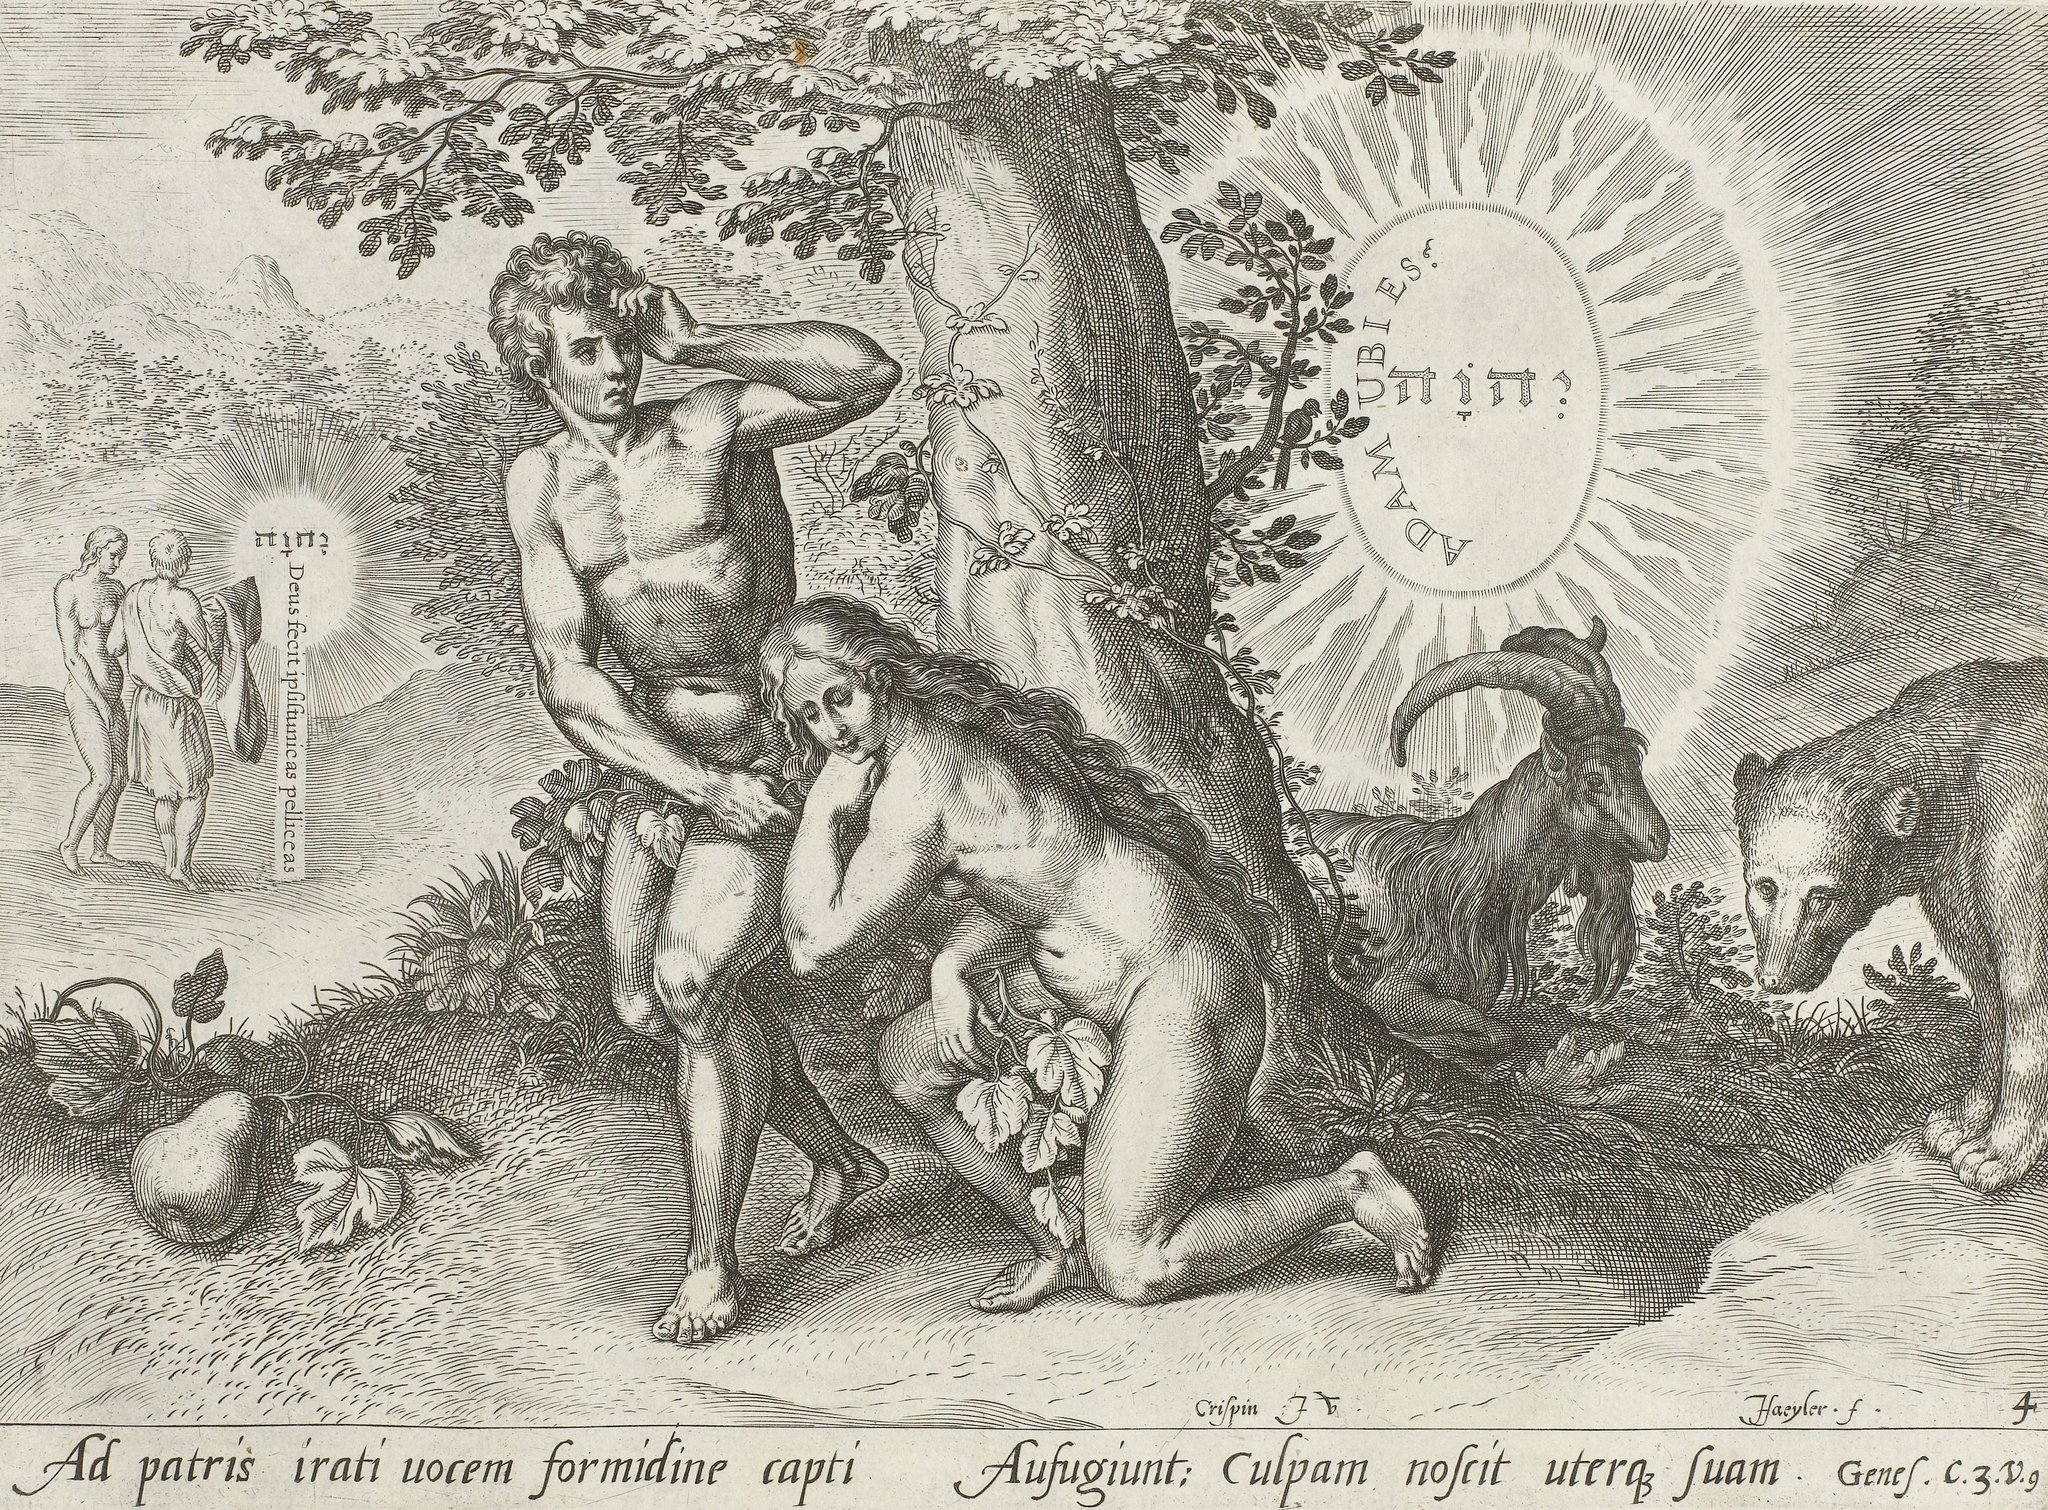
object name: album leaf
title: Schepping en zondeval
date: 1643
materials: paper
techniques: engraving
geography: amsterdam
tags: adam and eve are clothed by god, beasts of prey, predatory animals: bear, adam and eve hide from god, god calls adam and eve to account for their deed, adam and eve discover their nakedness; they cover themselves with their hands or with leaves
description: Adam en Eva hebben na het eten van een vrucht van de boom van de kennis van goed en kwaad ontdekt dat ze naakt zijn. Ze bedekken zich met bladeren en verbergen zich voor God achter een boom. God de Vader, in de gedaante van een stralenkrans rechts, zoekt ze en vraagt waar ze zijn. Links op de achtergrond geeft God de Vader, in de gedaante van het tetragram, kleren aan Adam en Eva. Rechts een beer. Onderaan een verwijzing naar de Bijbeltekst in het Latijn. Deze prent maakt deel uit van een album.